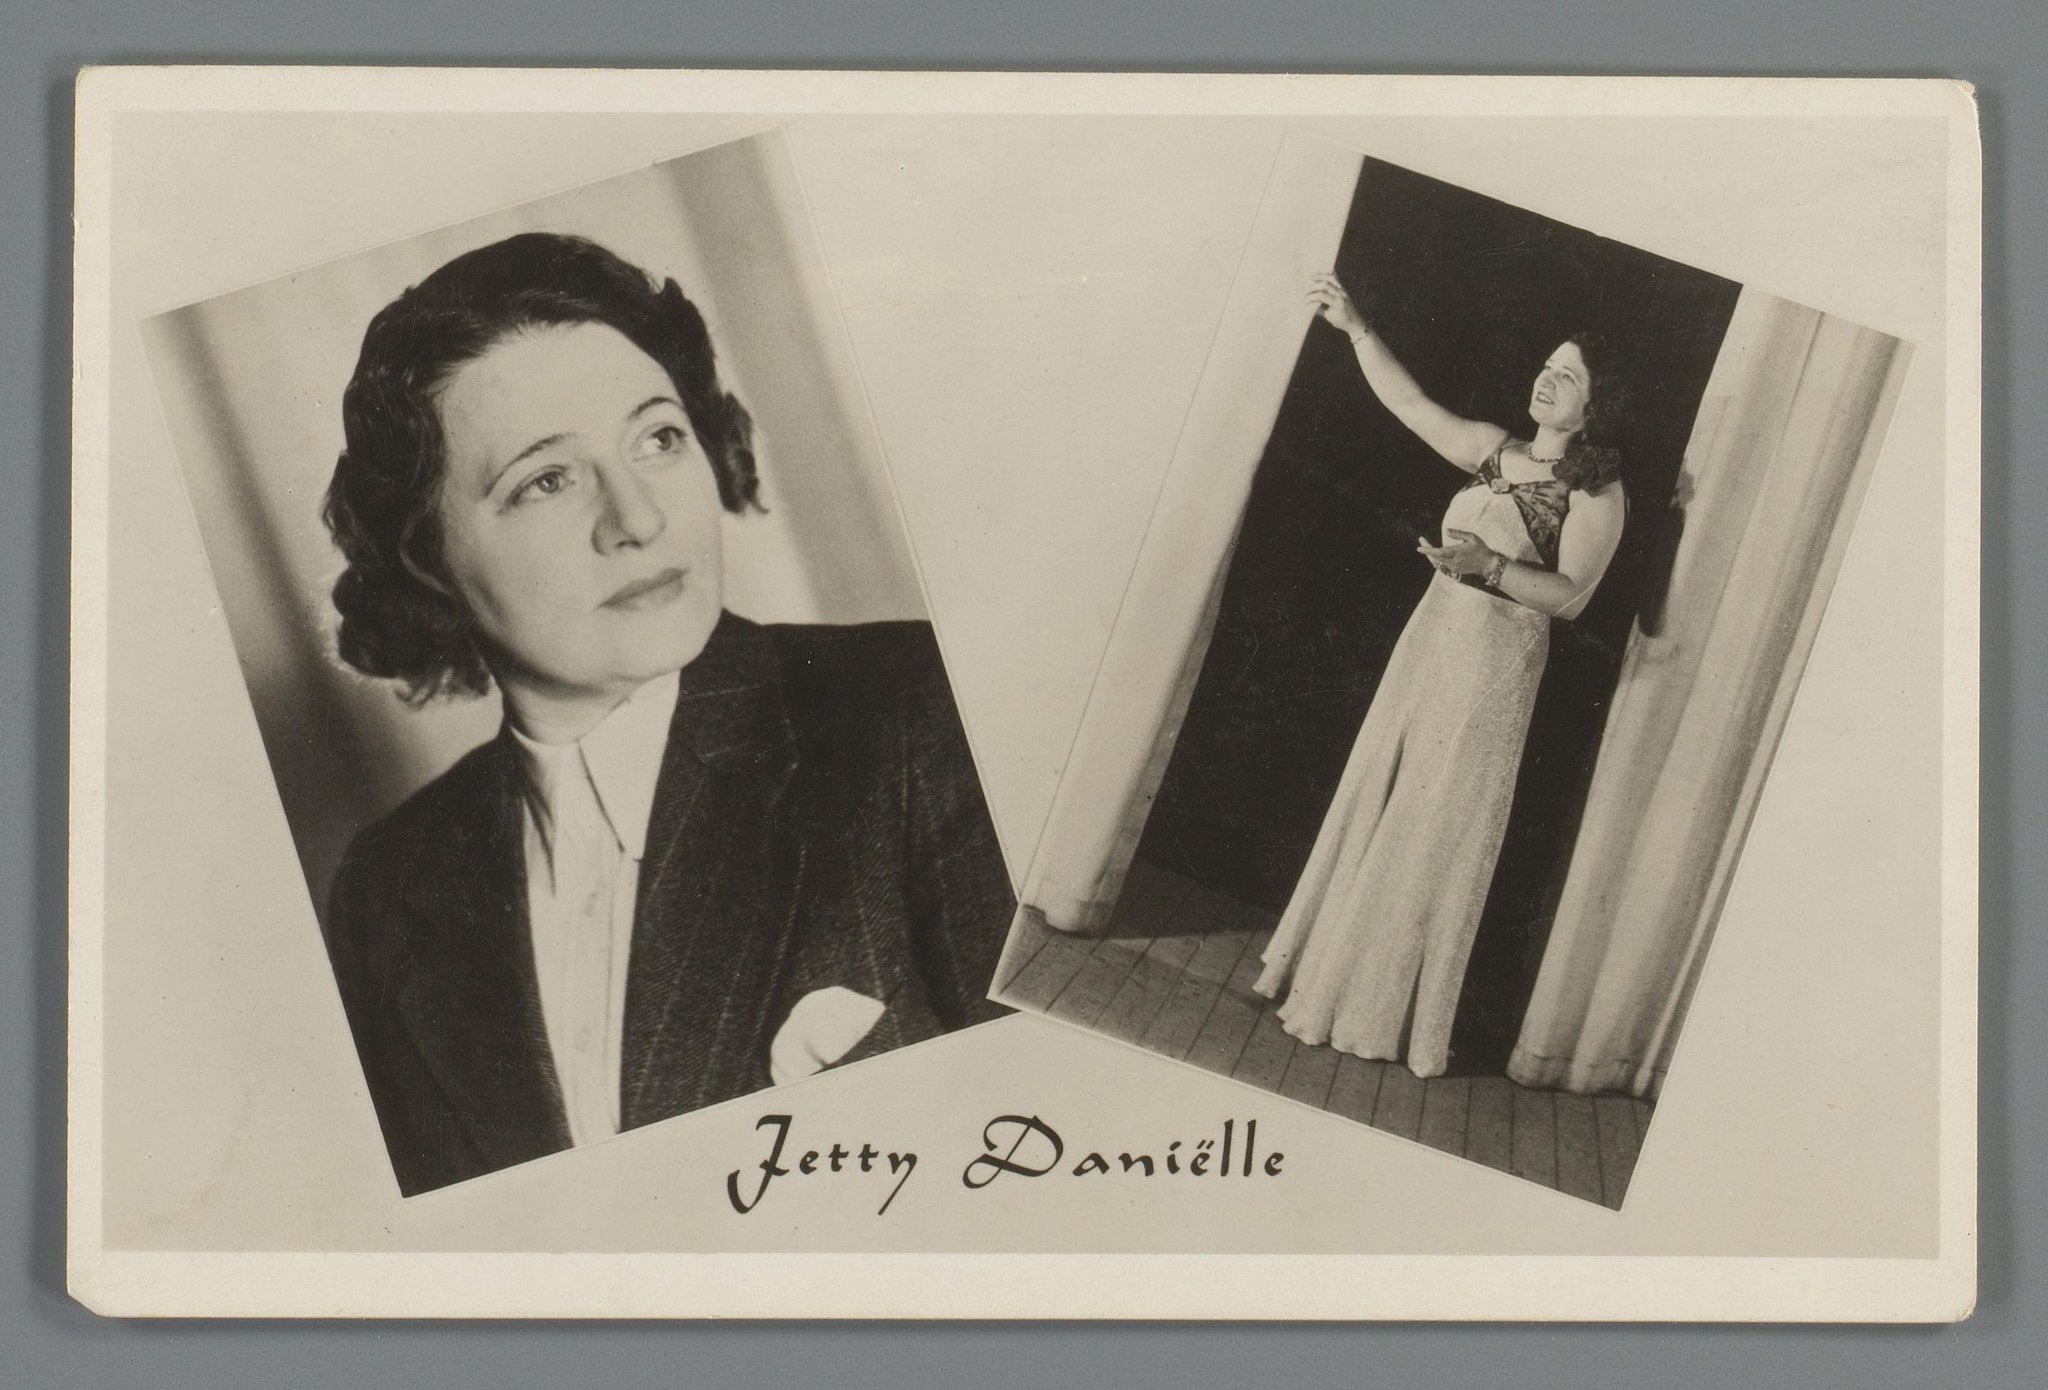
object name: photograph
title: Jetty Daniëlle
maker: Anonymous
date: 1920-1950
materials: paper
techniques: gelatin silver print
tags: historical persons - bb - woman, portrait of cabaret-artiste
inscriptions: stamp: ‘Jetty Daniëlle/ Cabaretière/ Jul. v. Stolberglaan 320 (...)’, inscription: ‘Jetty Merks’